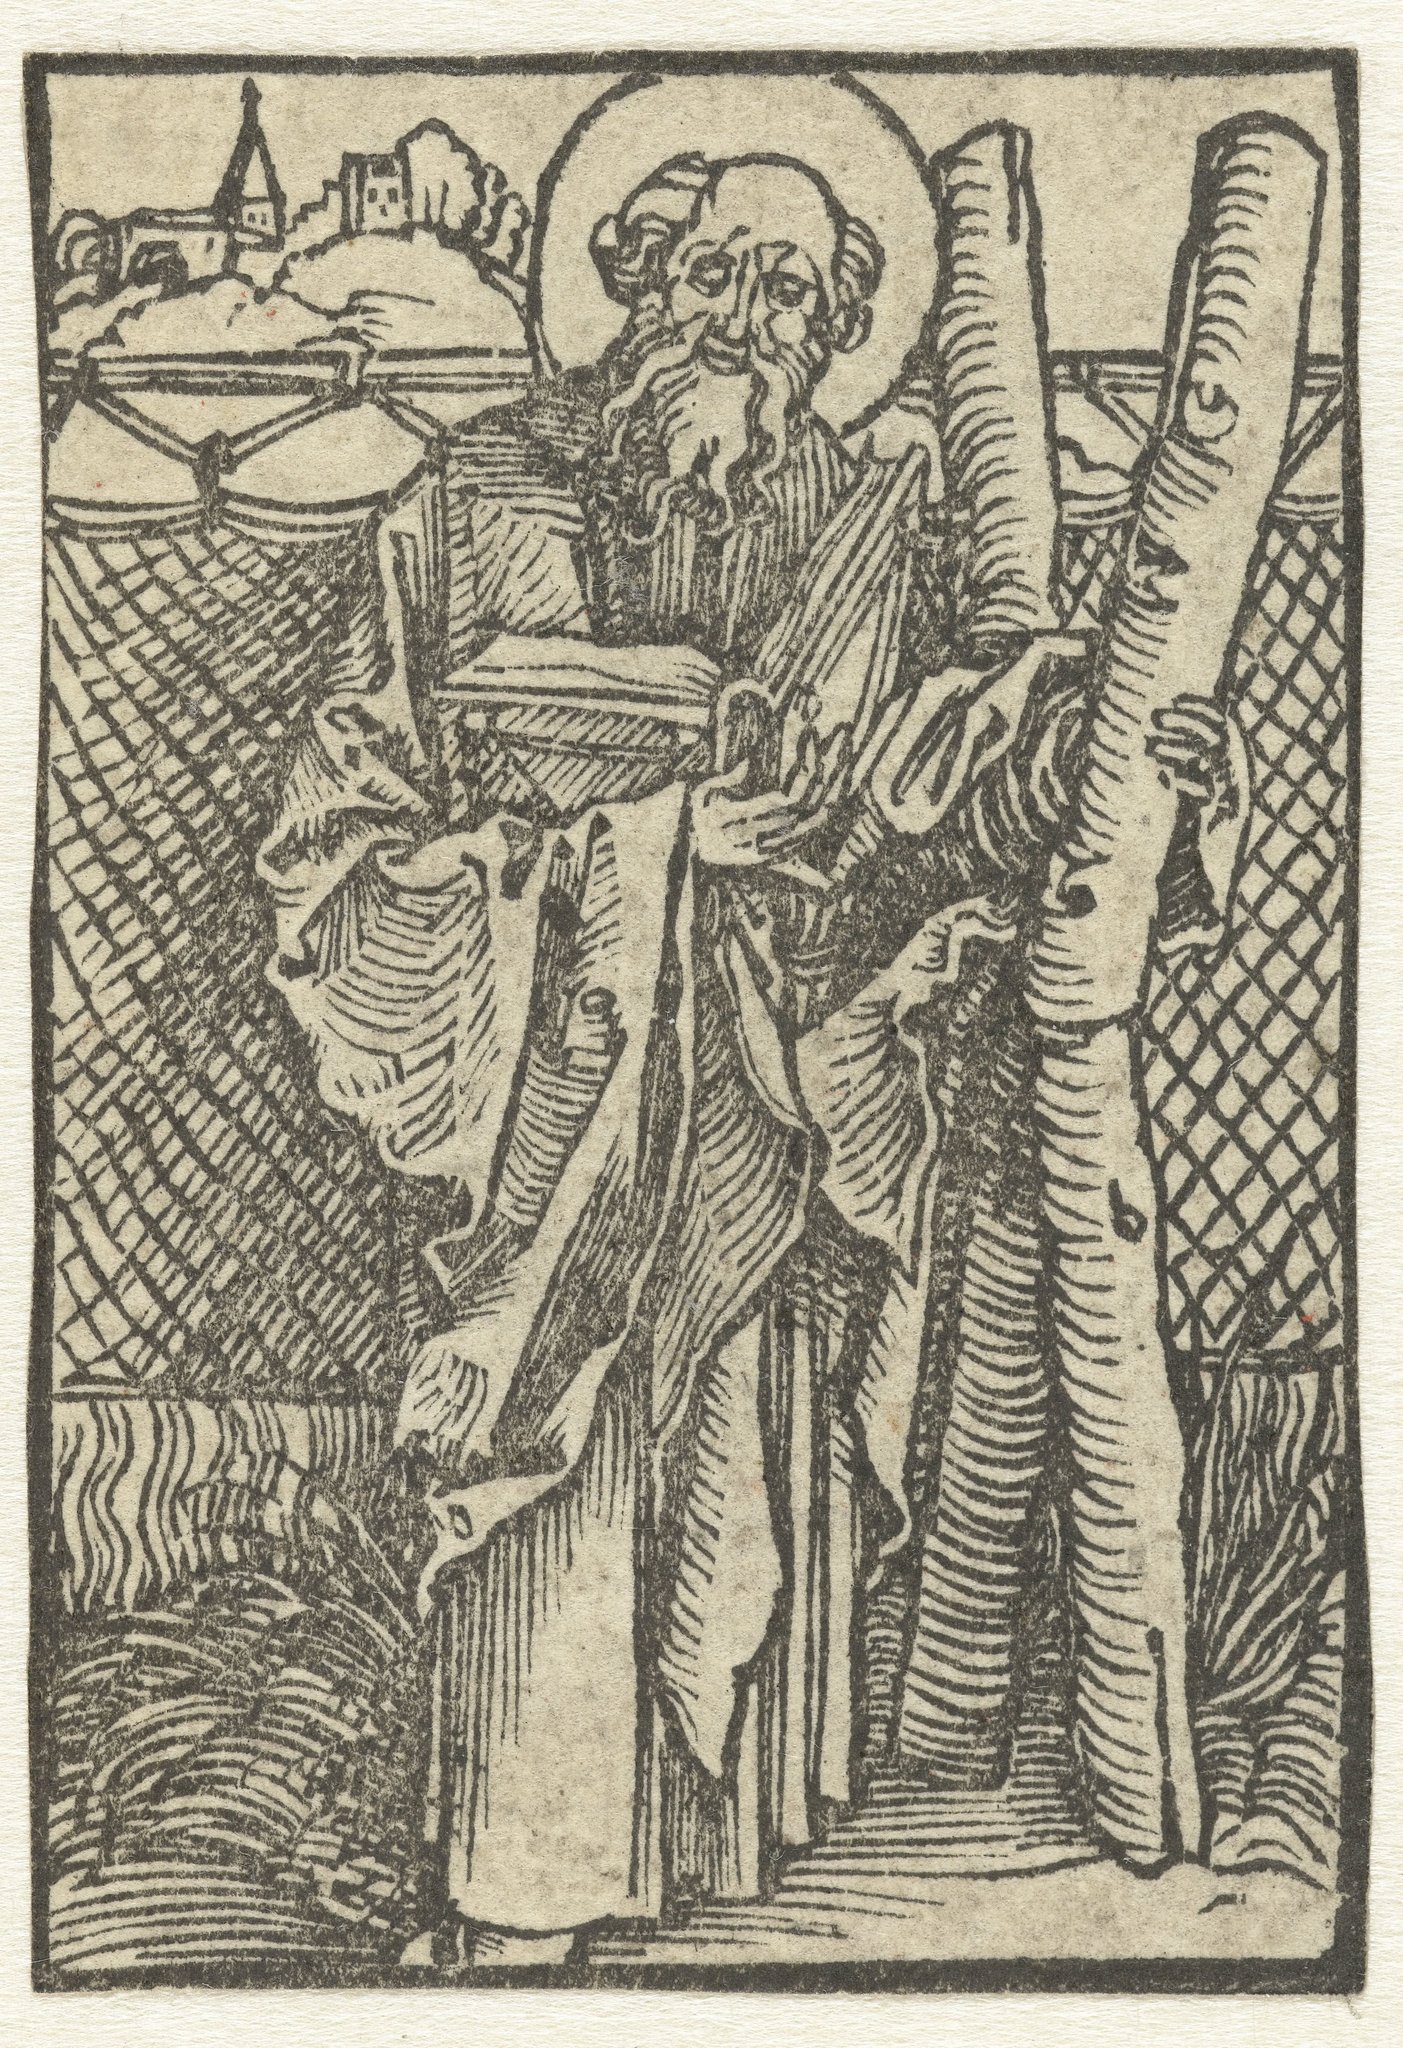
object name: print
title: Apostel Andreas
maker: albrecht dürer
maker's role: draughtsman, painter, print maker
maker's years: 1471-1528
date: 1503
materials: paper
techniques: woodcut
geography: nuremberg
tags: the apostle andrew; possible attributes: book, x-shaped cross, fish, fishing-net, rope, scroll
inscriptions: collector's mark: Lugt 240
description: Illustratie voor: Salus anim[a]e, Neurenberg: Hieronymus Höltzel, 1503. Klinkert, C.